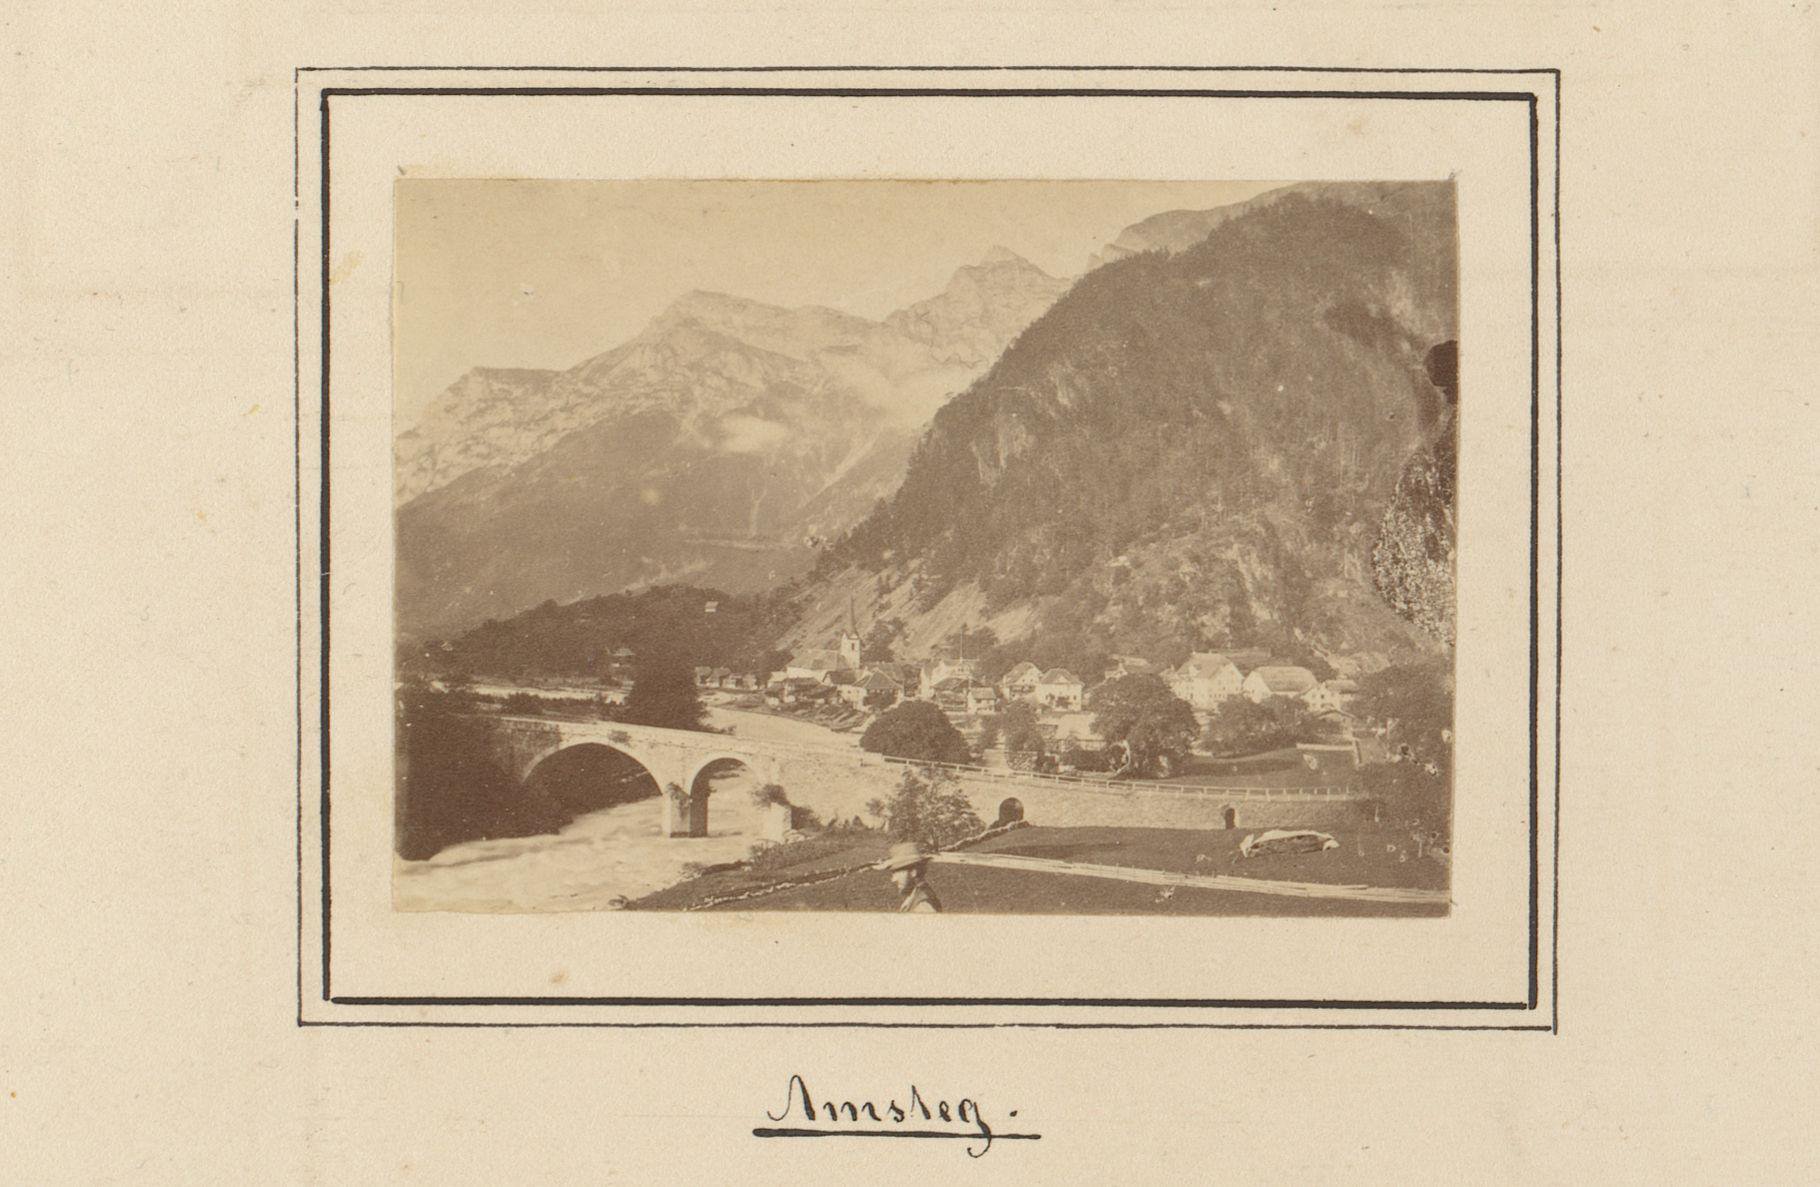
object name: album leaf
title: Gezicht op Amsteg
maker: Anonymous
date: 1870-1890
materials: paper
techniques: albumen print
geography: amsteg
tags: prospect of village, silhouette of village